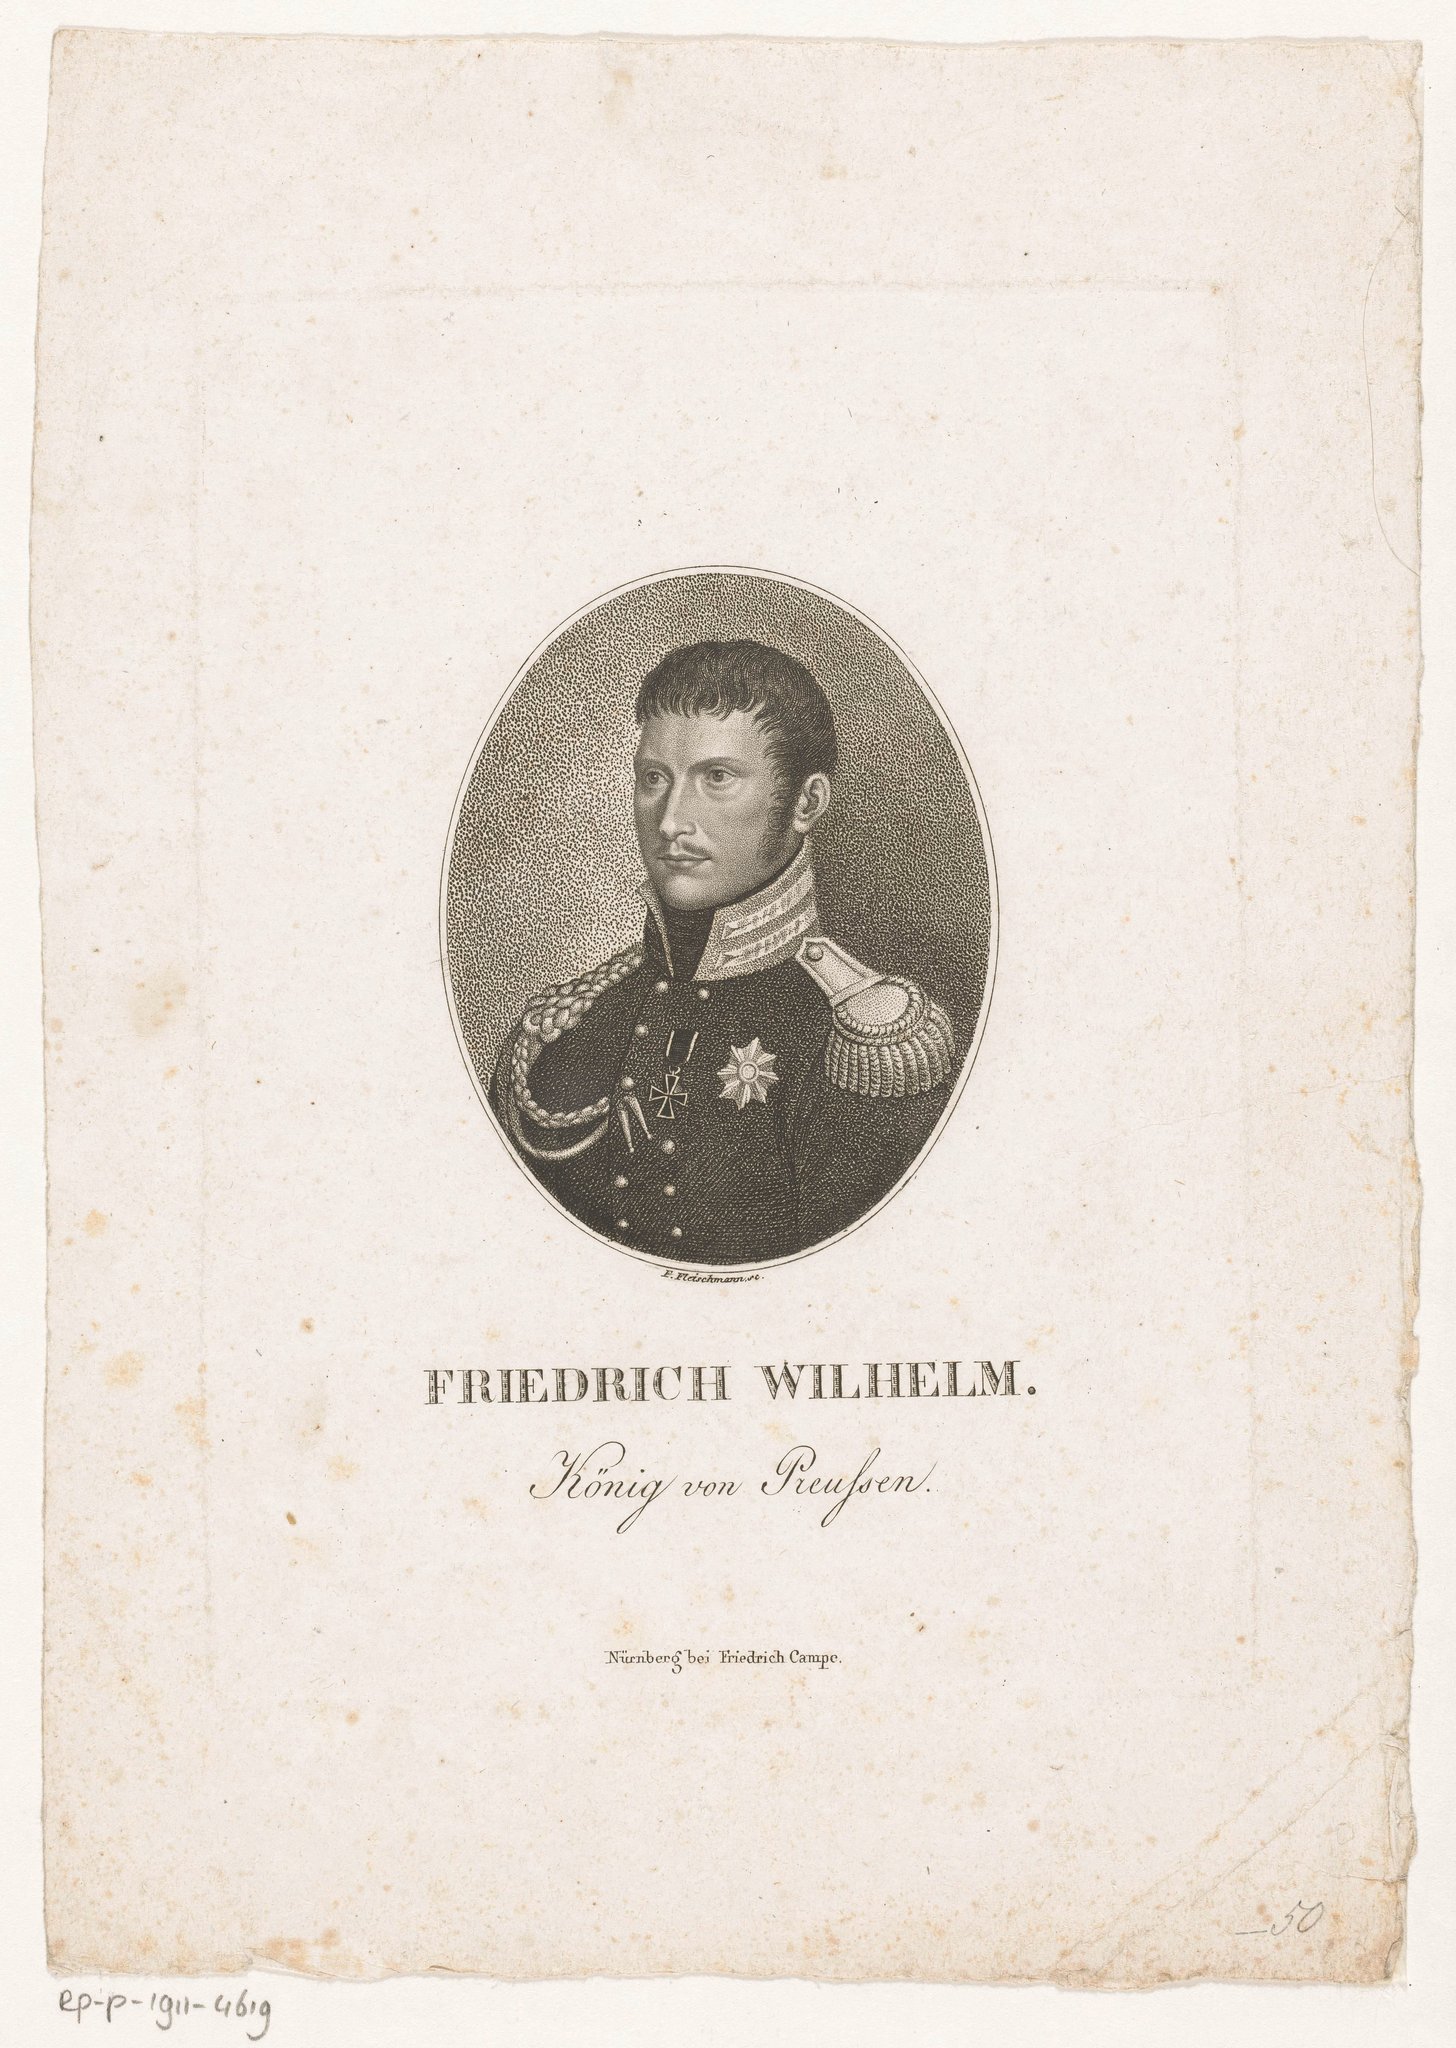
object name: print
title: Portret van Frederik Willem III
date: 1801-1834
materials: paper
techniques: engraving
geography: nuremberg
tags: berlin, frederik willem iii koning van pruisen, historical persons, ruler, sovereign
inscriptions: collector's mark: Lugt 2228